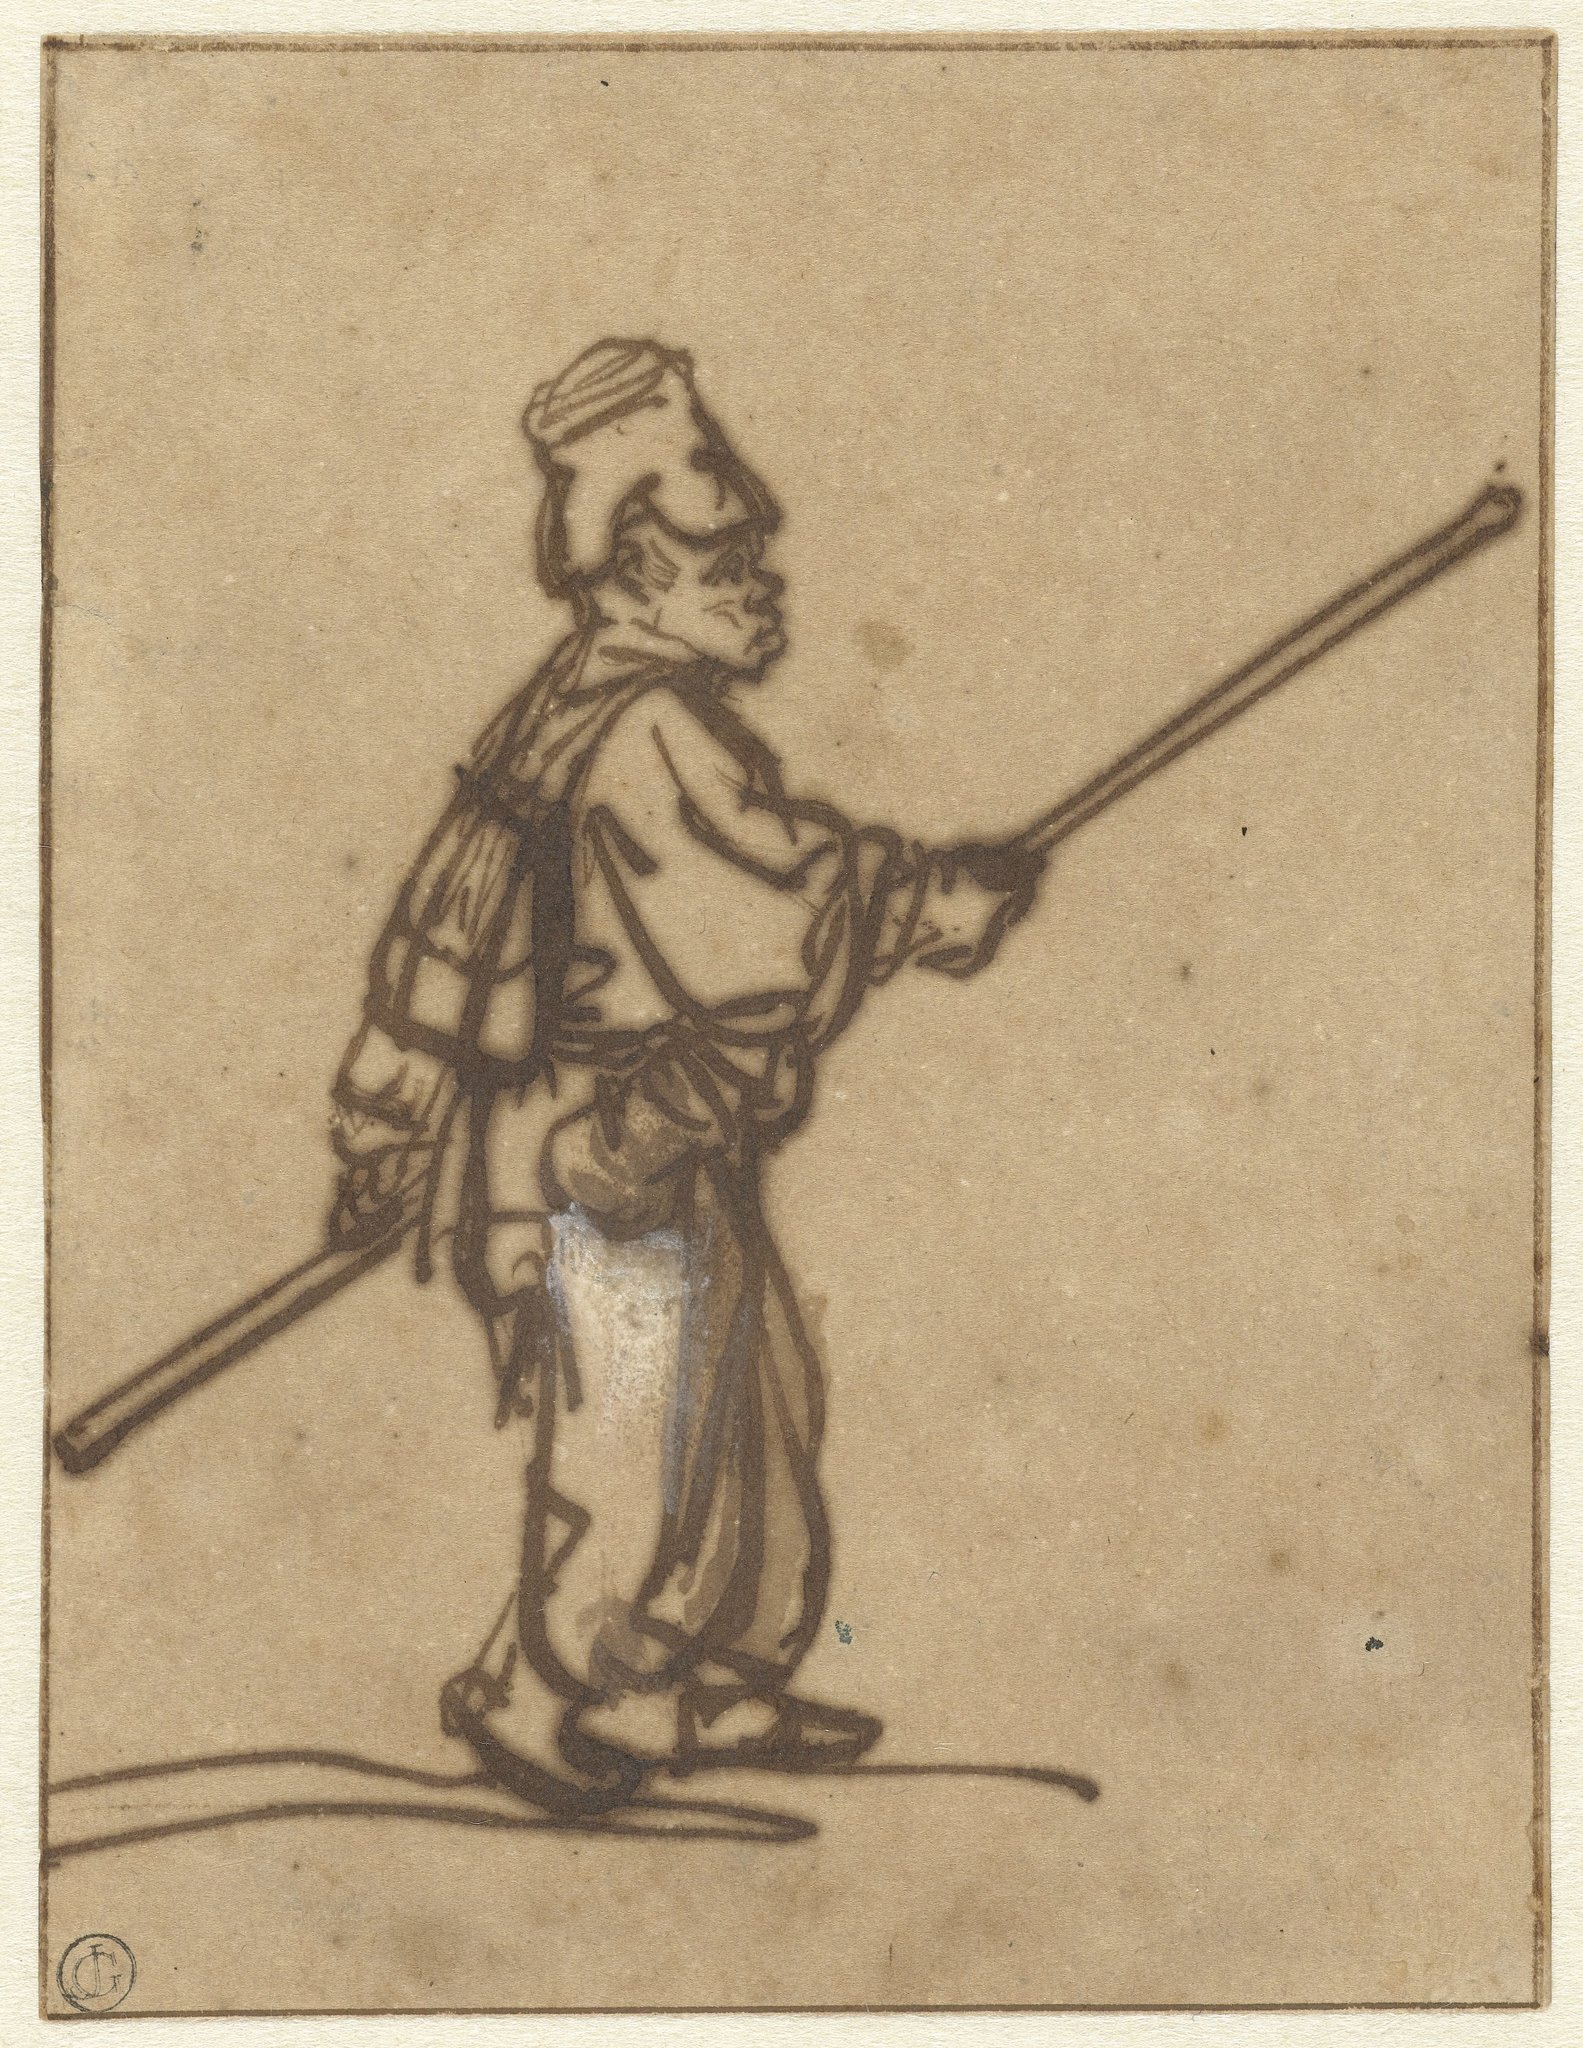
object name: drawing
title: Boy Walking with a Stick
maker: rembrandt van rijn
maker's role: draughtsman, painter, print maker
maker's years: 1606-1669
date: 1635-1640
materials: ink, paint, paper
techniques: brush, pen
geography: amsterdam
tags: standing figure, youth, adolescent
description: Why this boy is holding a stick is unclear. Rembrandt may have portrayed a victim of leprosy, who was required to carry a stick to warn his healthy fellow citizens. Rembrandt deliberately did not draw the stick entirely straight, giving it a more natural appearance. He used iron gall ink, notorious for eating holes through paper, so-called ink corrosion.